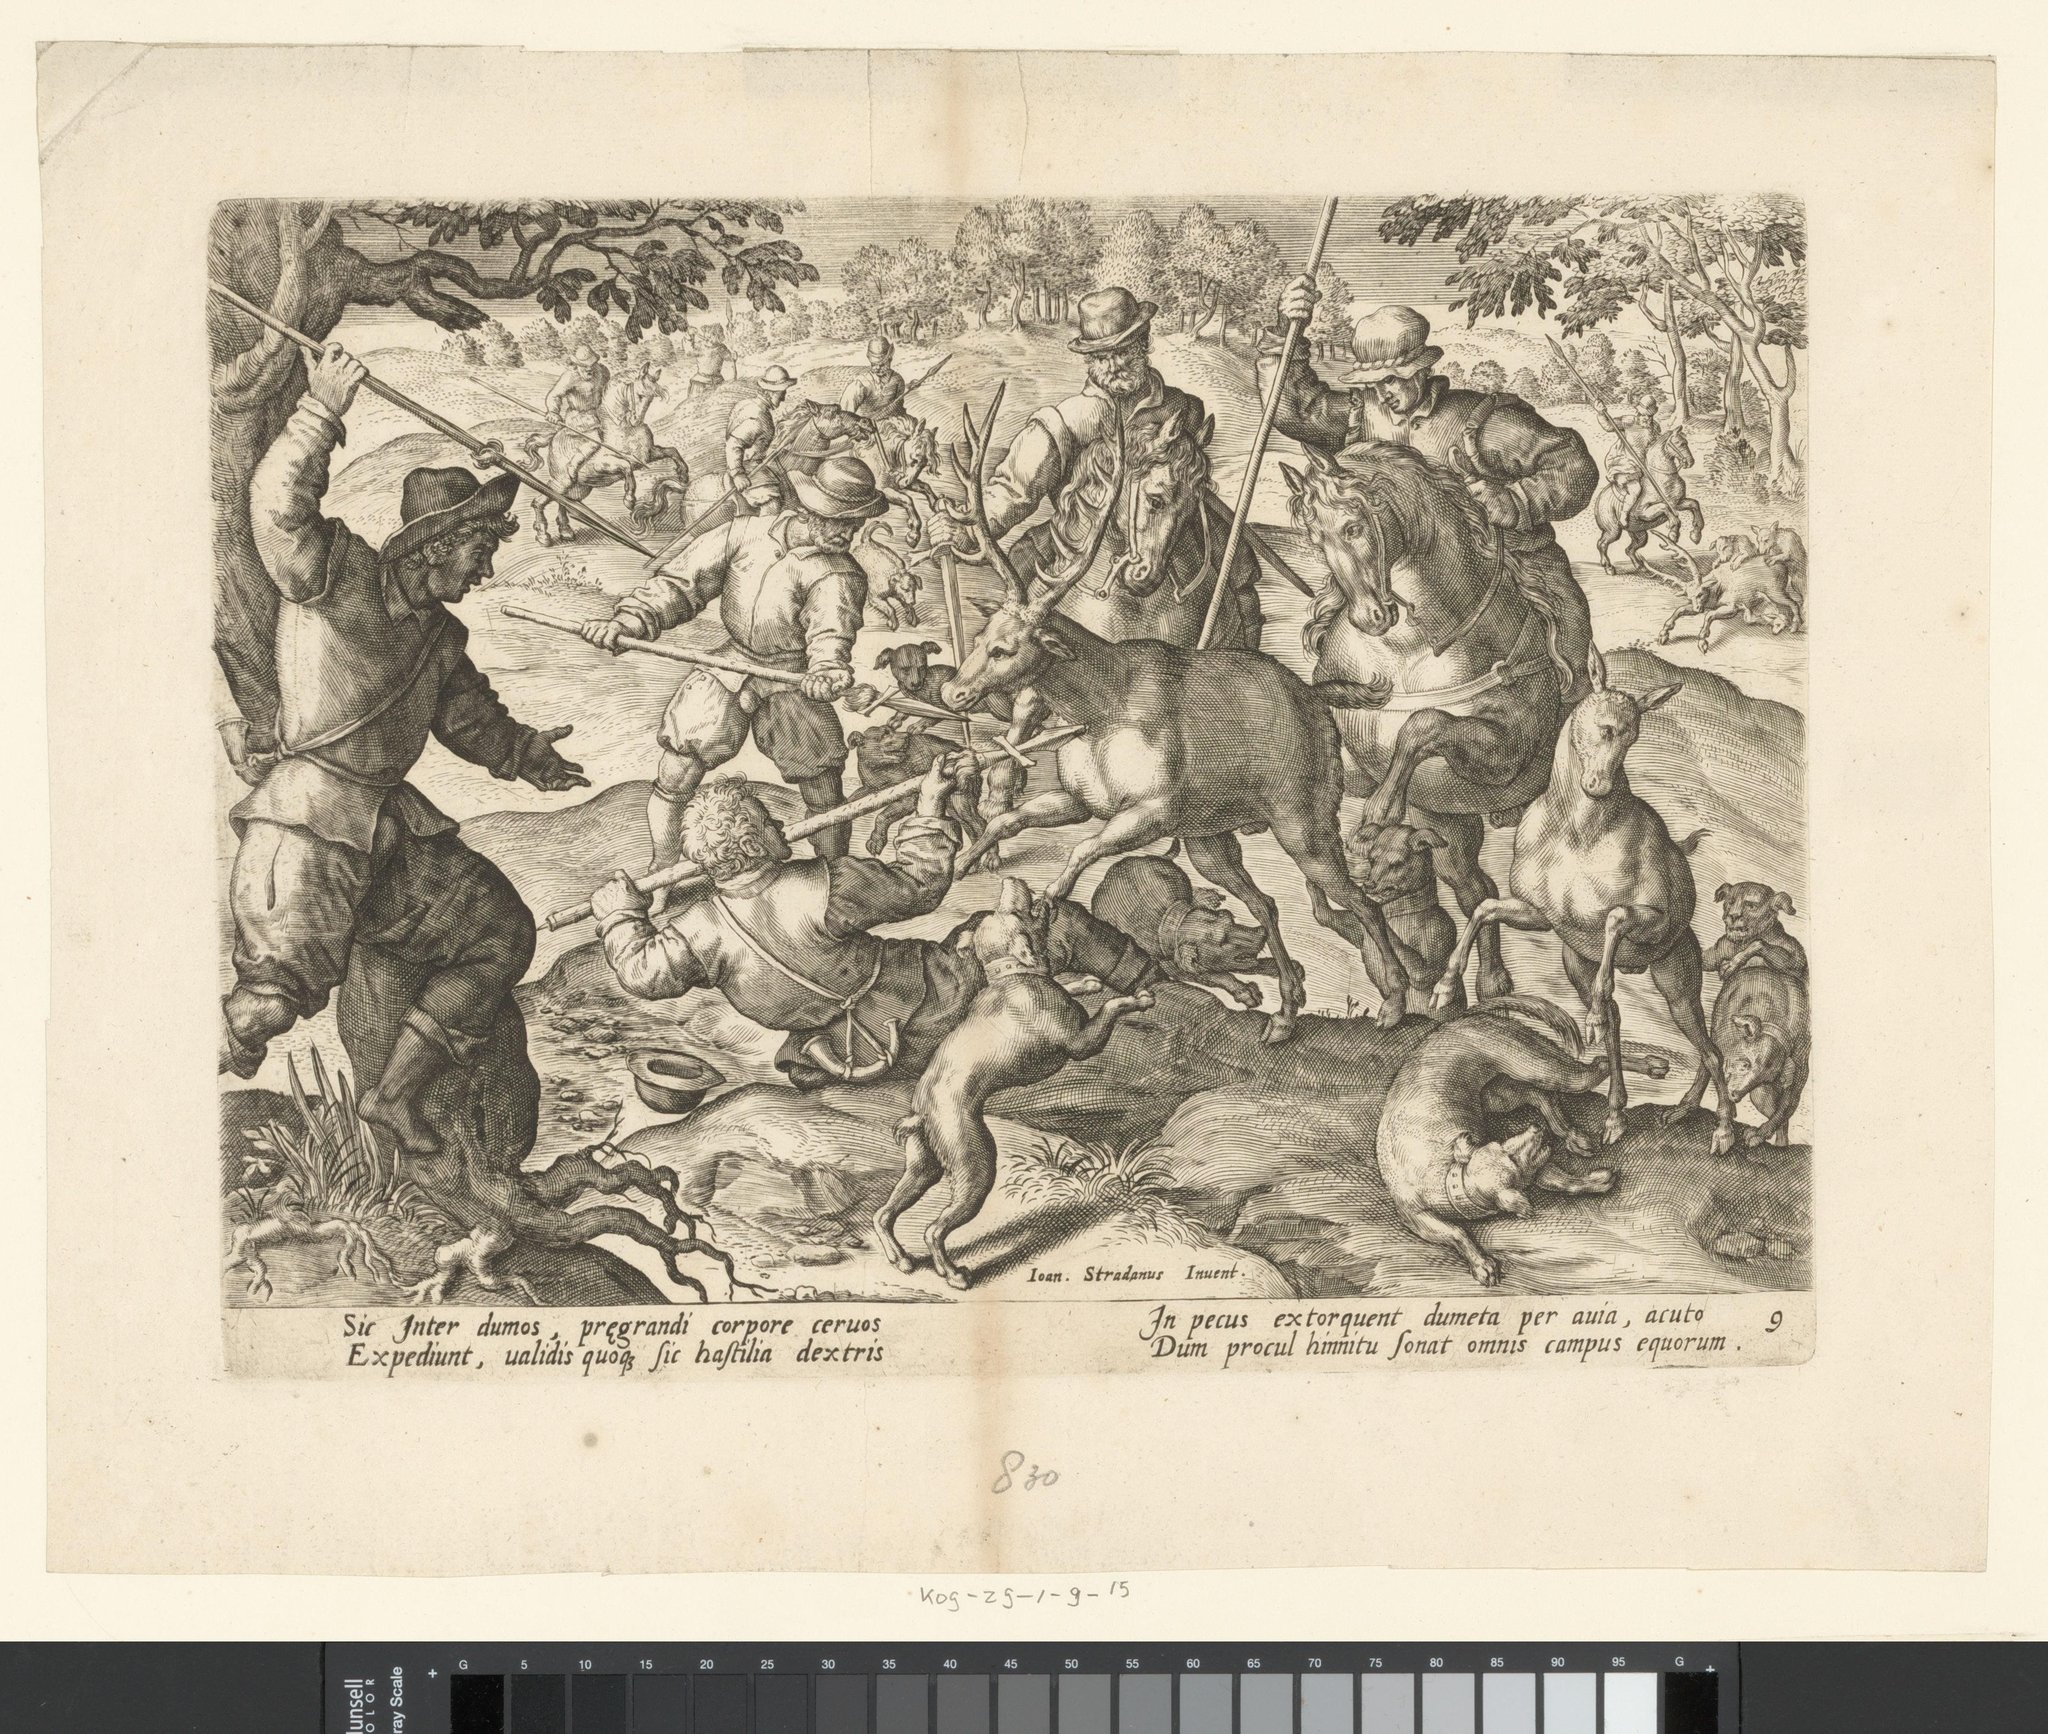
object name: print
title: Jachttaferelen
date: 1567-1601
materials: paper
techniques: engraving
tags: hoofed animals: deer, stag-hunting, hunters hunting (n.b.: in 1988-1990 this notation denoted the concept of 43c11421 'hunters resting during the hunt')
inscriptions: collector's mark: Lugt 1641, stamp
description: Mannen jagen, deels te paard en deels te voet, met speren en zwaarden op herten. Ze worden geholpen door enkele honden. Onder de voorstelling een vierregelig vers in het Latijn. Rechtsonder genummerd: 9. Onderwerpsrubrieken binnen de Atlas Zeden en Gewoonten: Handel, nijverheid en verkeer, jacht.